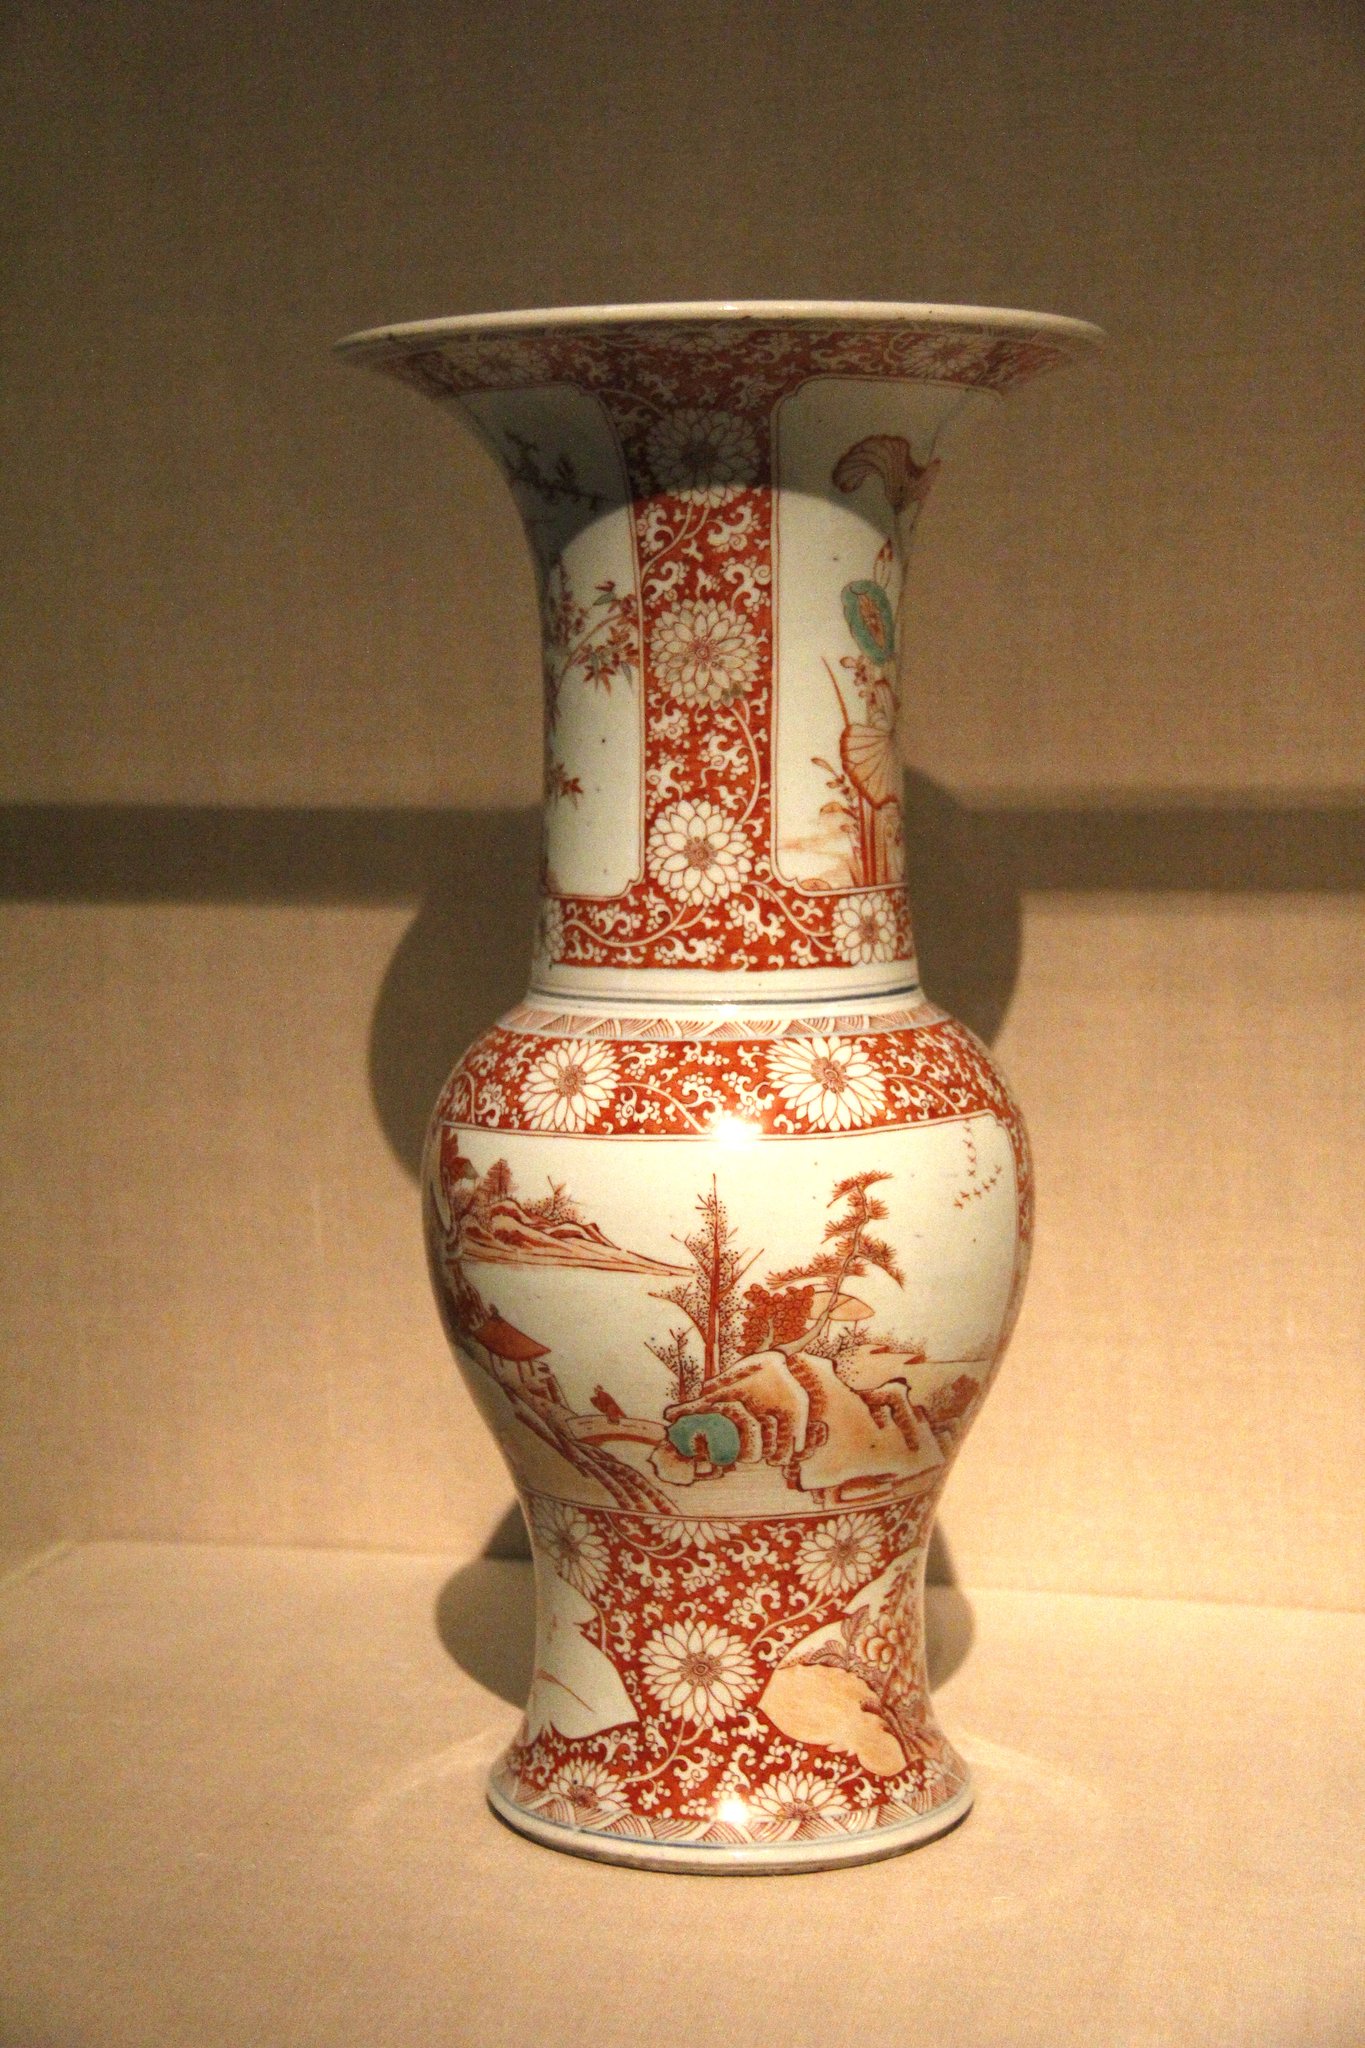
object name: beaker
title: Vase with landscape, flowers, and gardens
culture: chinese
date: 1622-1722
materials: copper, porcelain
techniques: painting, underglaze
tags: insects,landscapes